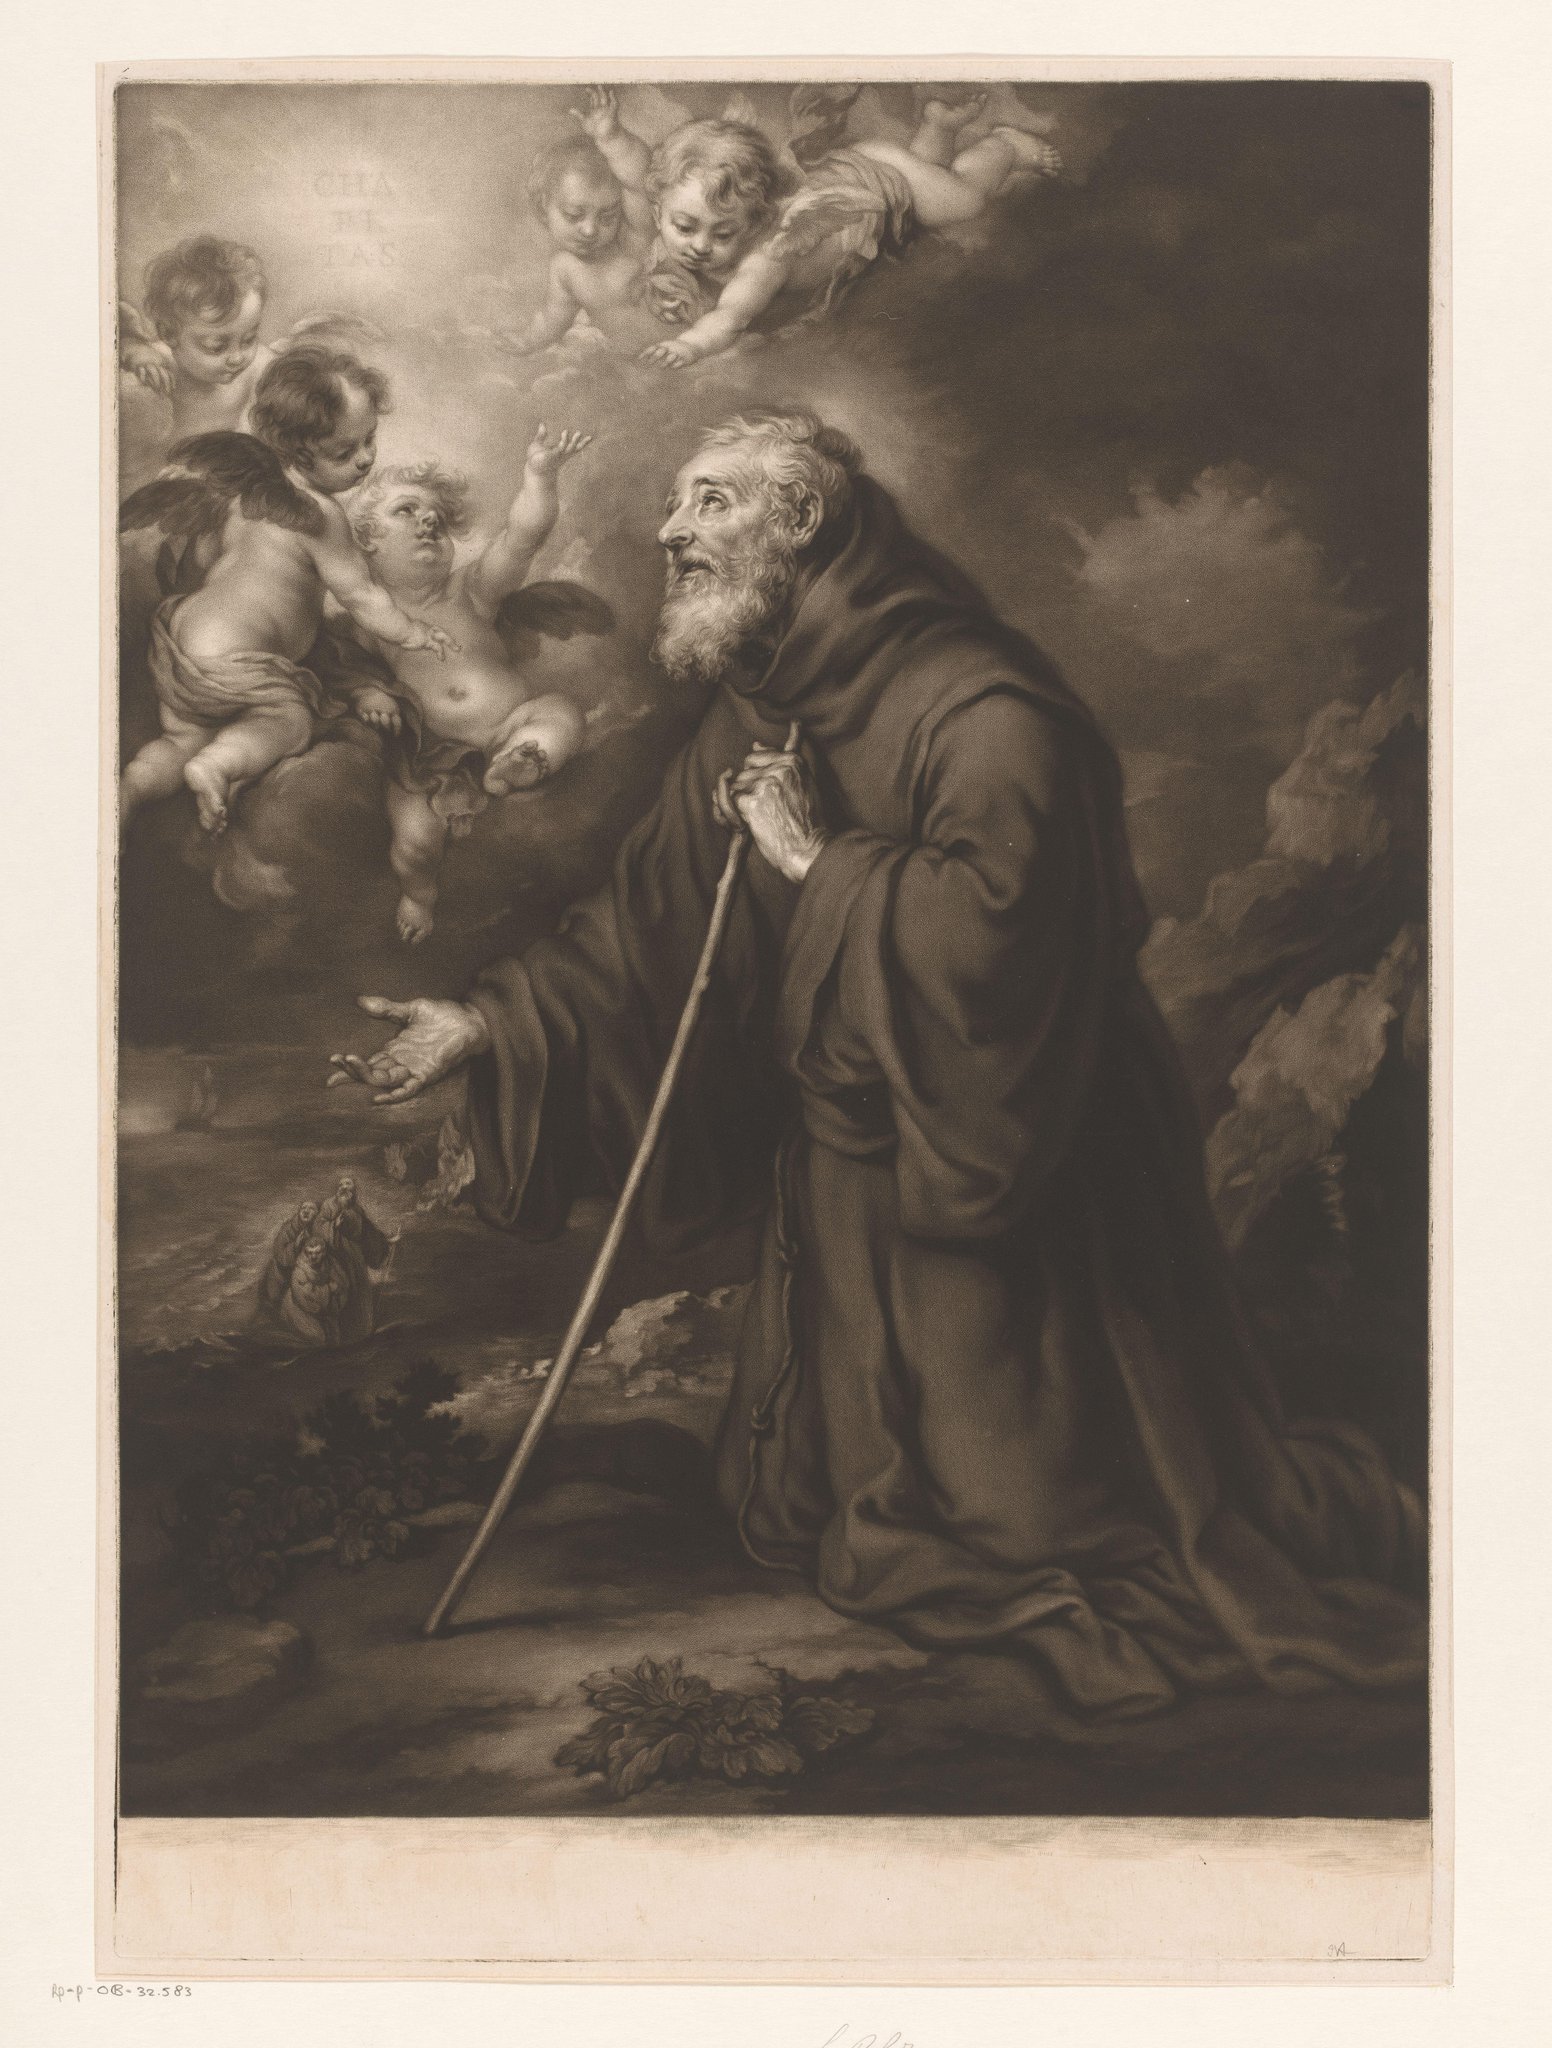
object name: print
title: Knielende H. Franciscus van Paola in gebed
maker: james mcardell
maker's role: print maker, publisher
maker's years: 1728-1765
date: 1746-1765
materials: paper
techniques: mezzotint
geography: london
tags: historical persons, one or more angels appear to st. francis of paola holding a tablet with the inscription 'charitas'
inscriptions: collector's mark: Lugt 240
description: Hij kijkt op naar vijf putti en een wolk waarin 'Charitas' staat. Links in de achtergrond drie monniken die omhoogkijken.